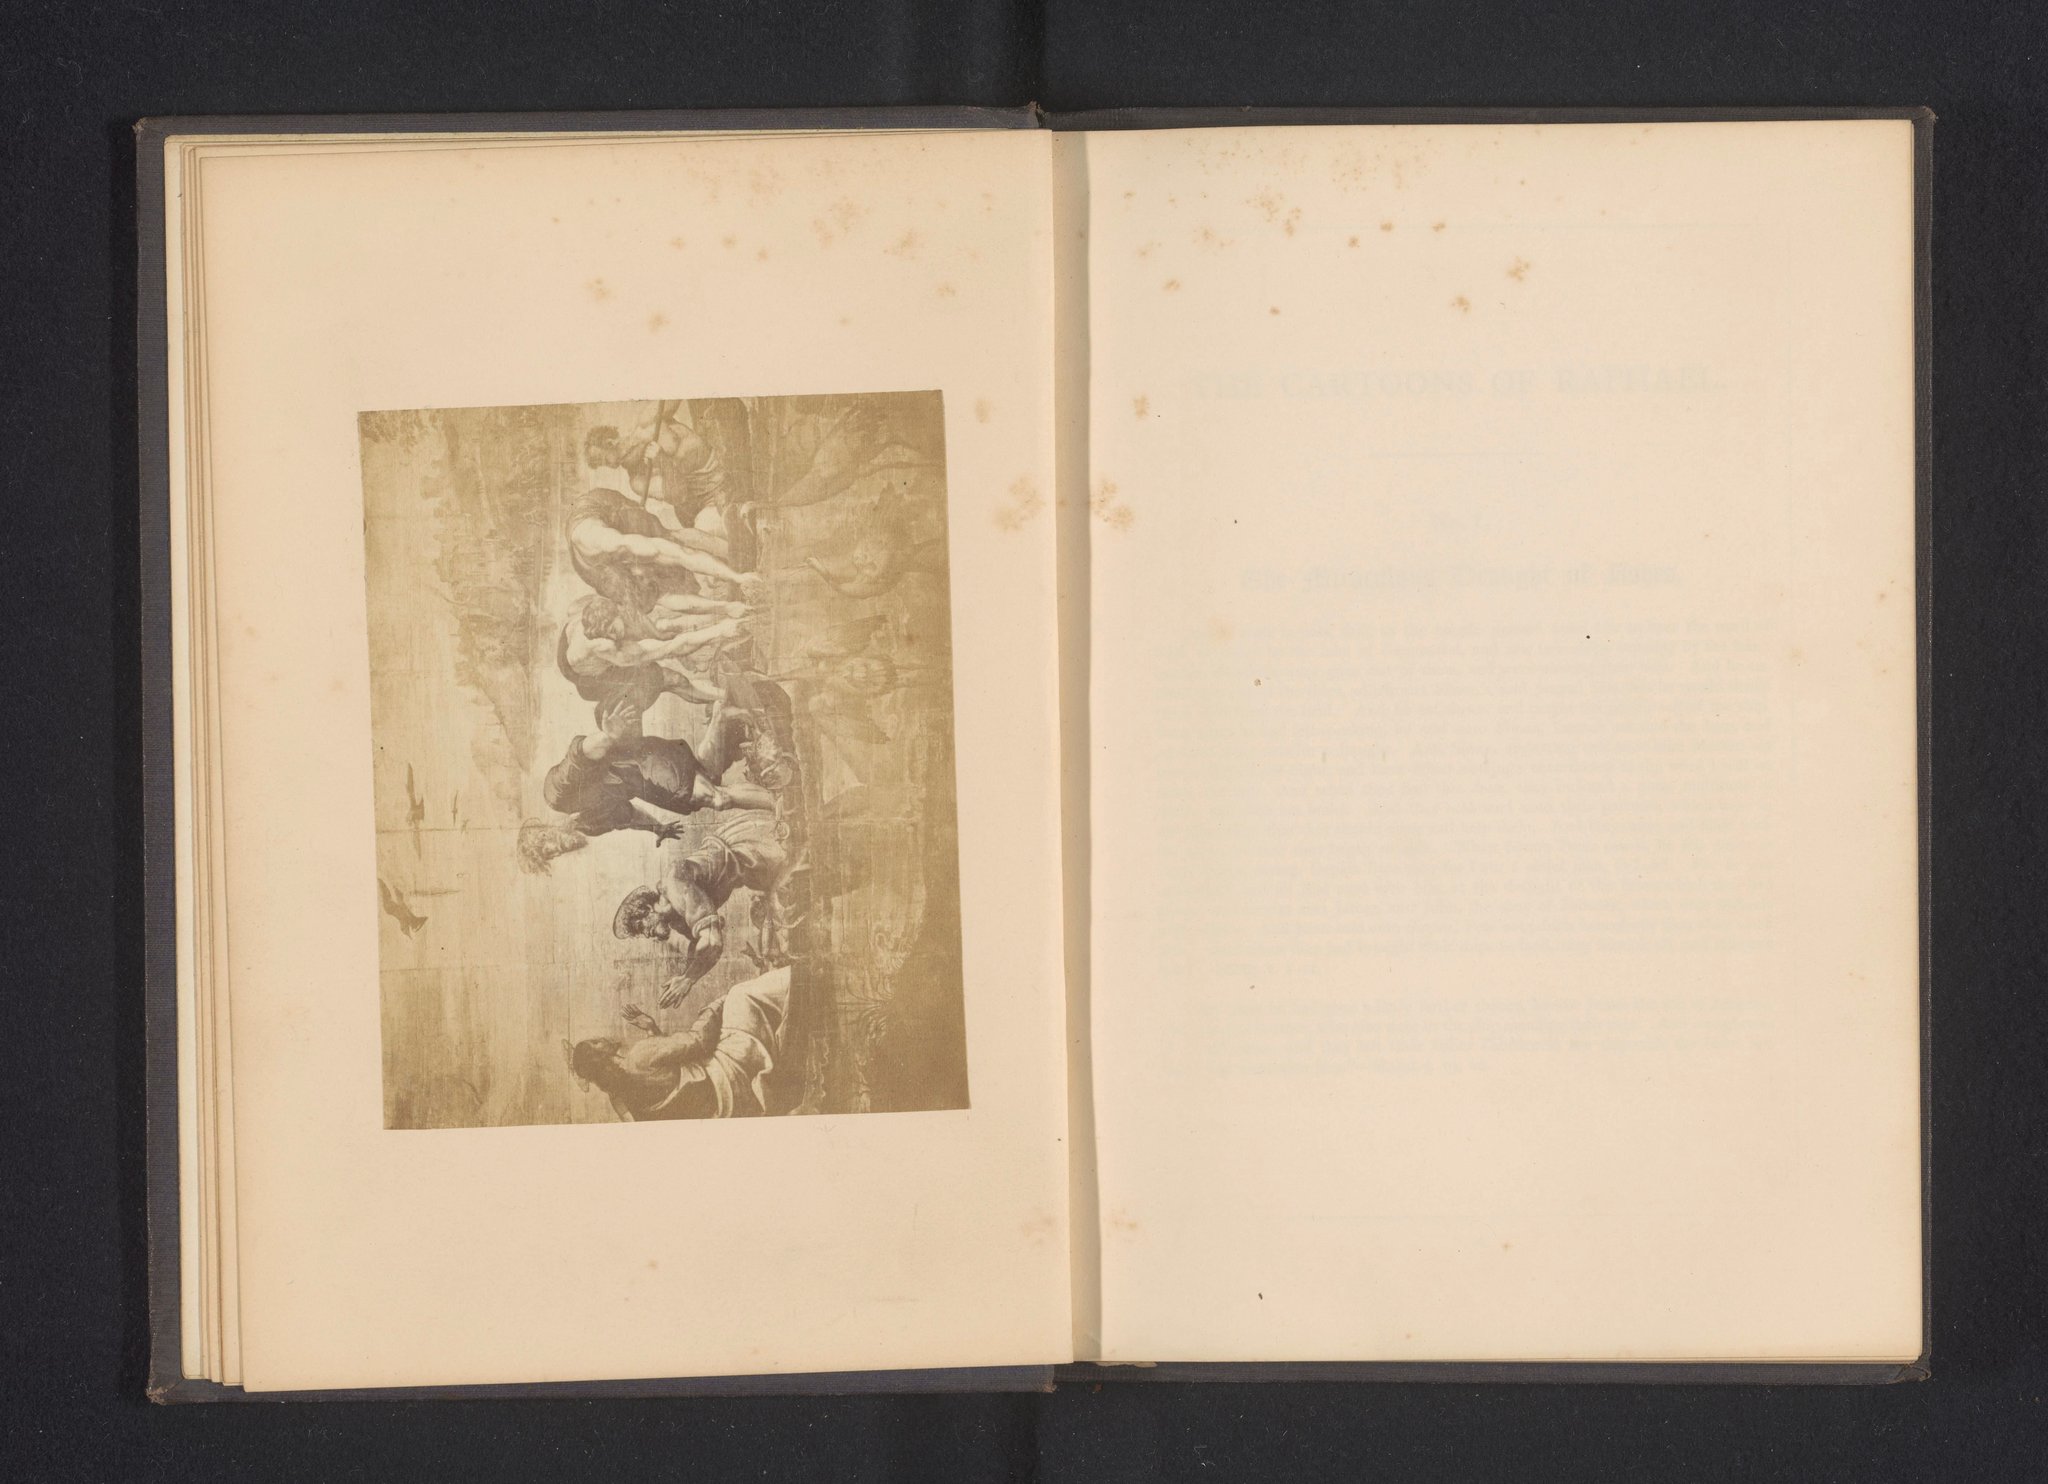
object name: reproduction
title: Fotoreproductie van een kartonschildering, voorstellende de wonderlijke visvangst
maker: Anonymous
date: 1850-1860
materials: photographic support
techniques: albumen print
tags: the miraculous draught of fishes (before the resurrection) on the lake of gennesaret (sea of galilee); james and john helping to bring in the nets (luke 5:1-11)